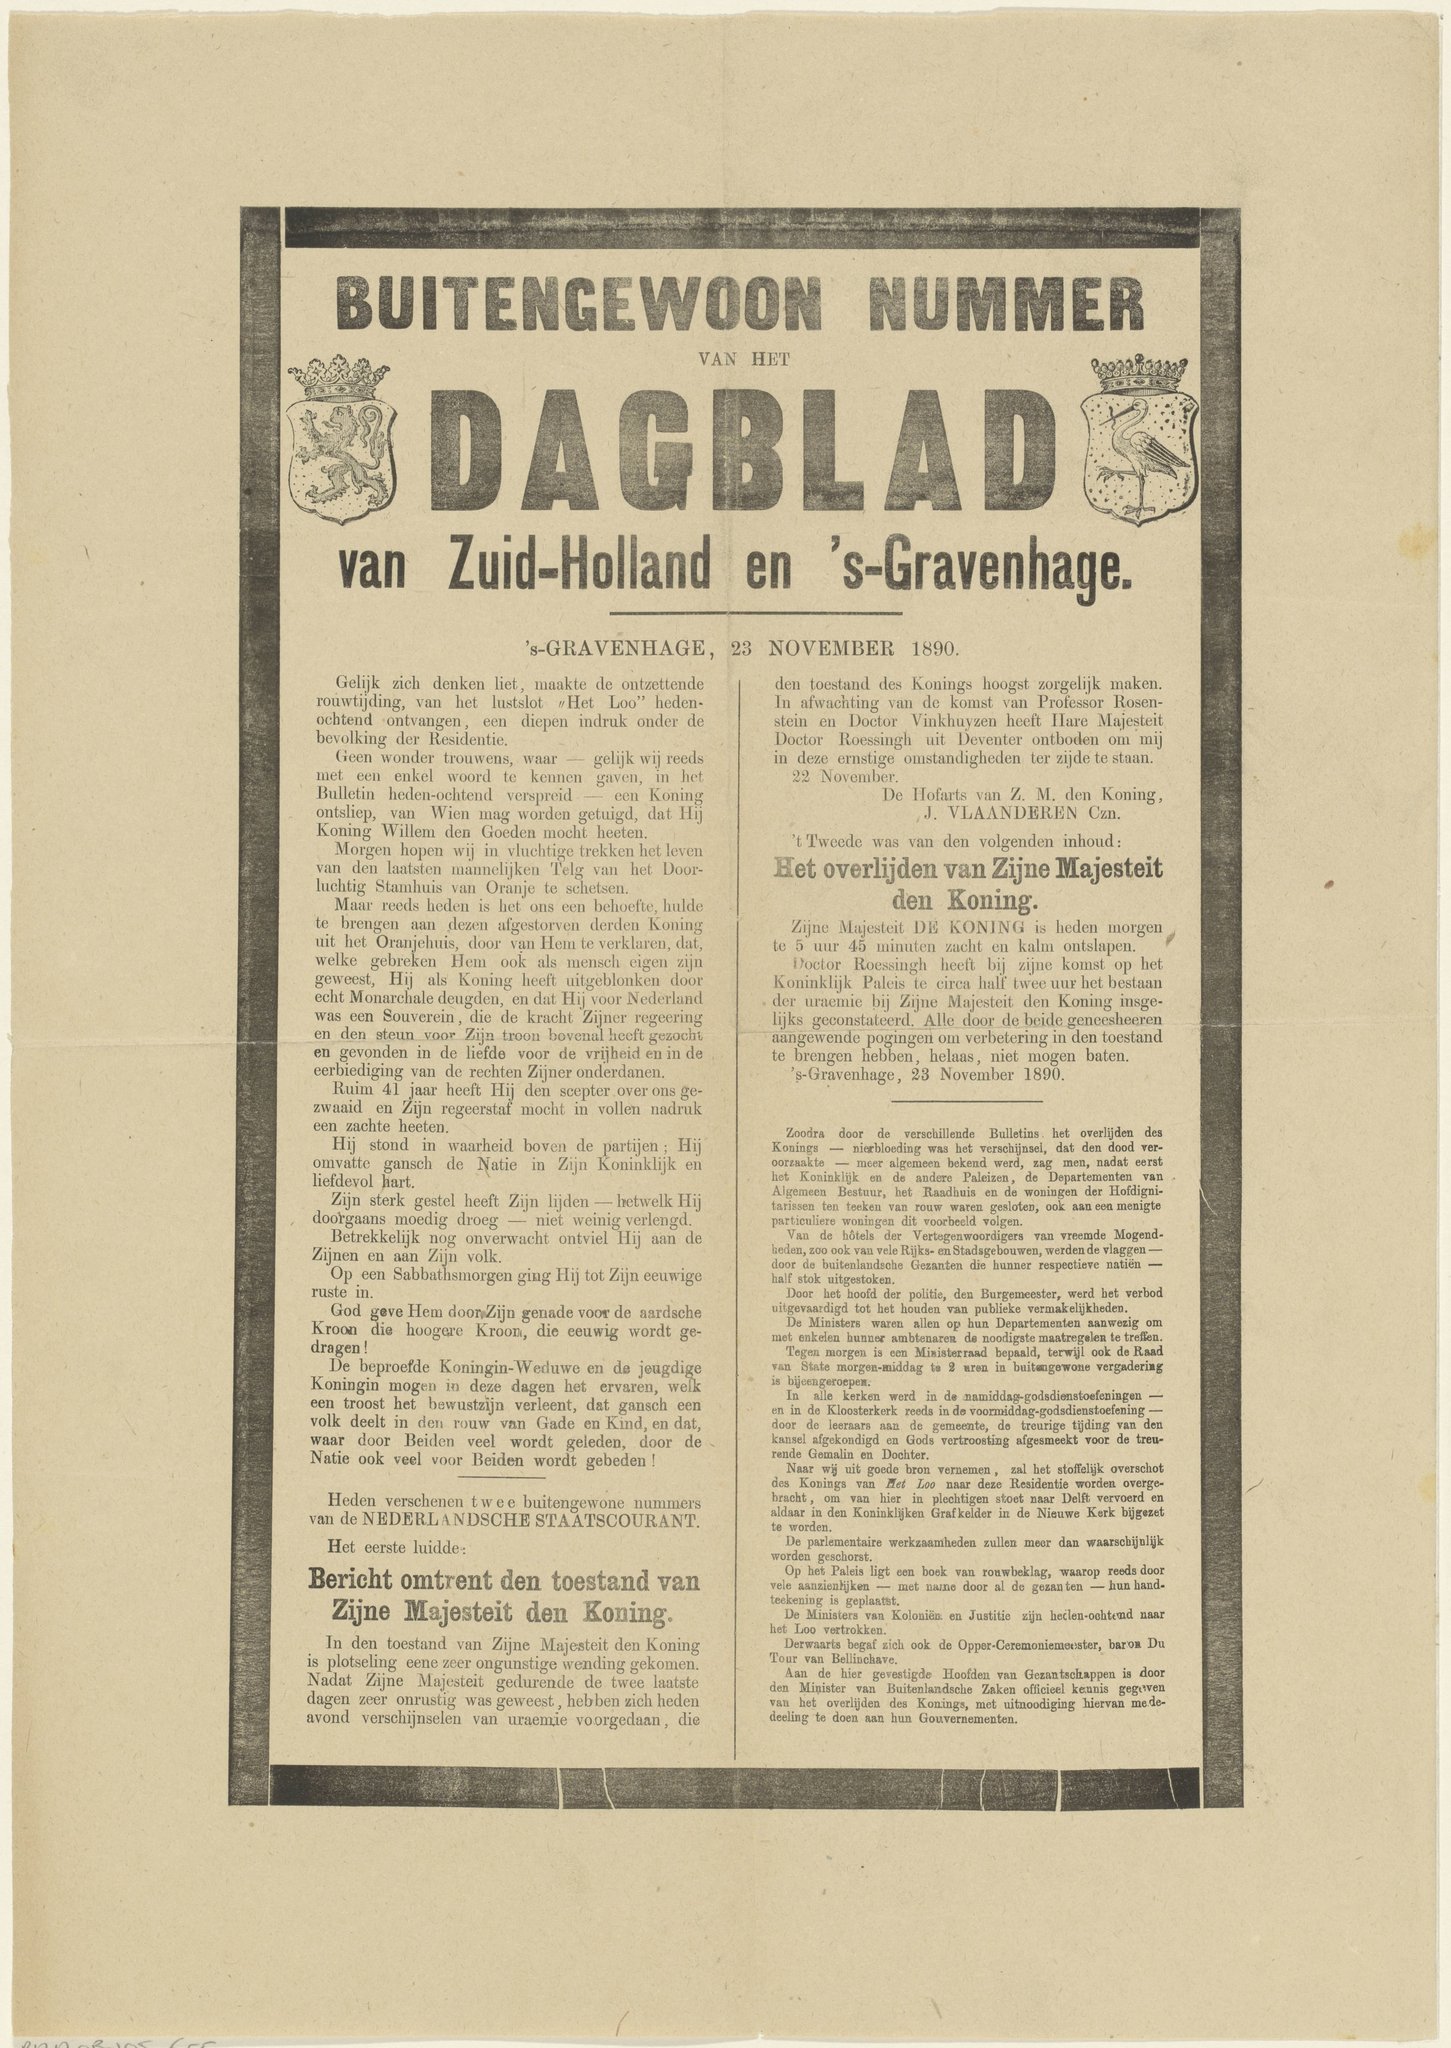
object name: newspaper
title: Buitengewoon nummer van het Dagblad van Zuid-Holland en 's Gravenhage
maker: Anonymous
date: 1890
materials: paper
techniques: letterpress printing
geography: netherlands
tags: brussels, willem iii (koning der nederlanden)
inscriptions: date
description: Buitengewoon nummer over het overlijden van Willem III in Paleis Noordeinde te Den Haag op 23 november 1890.